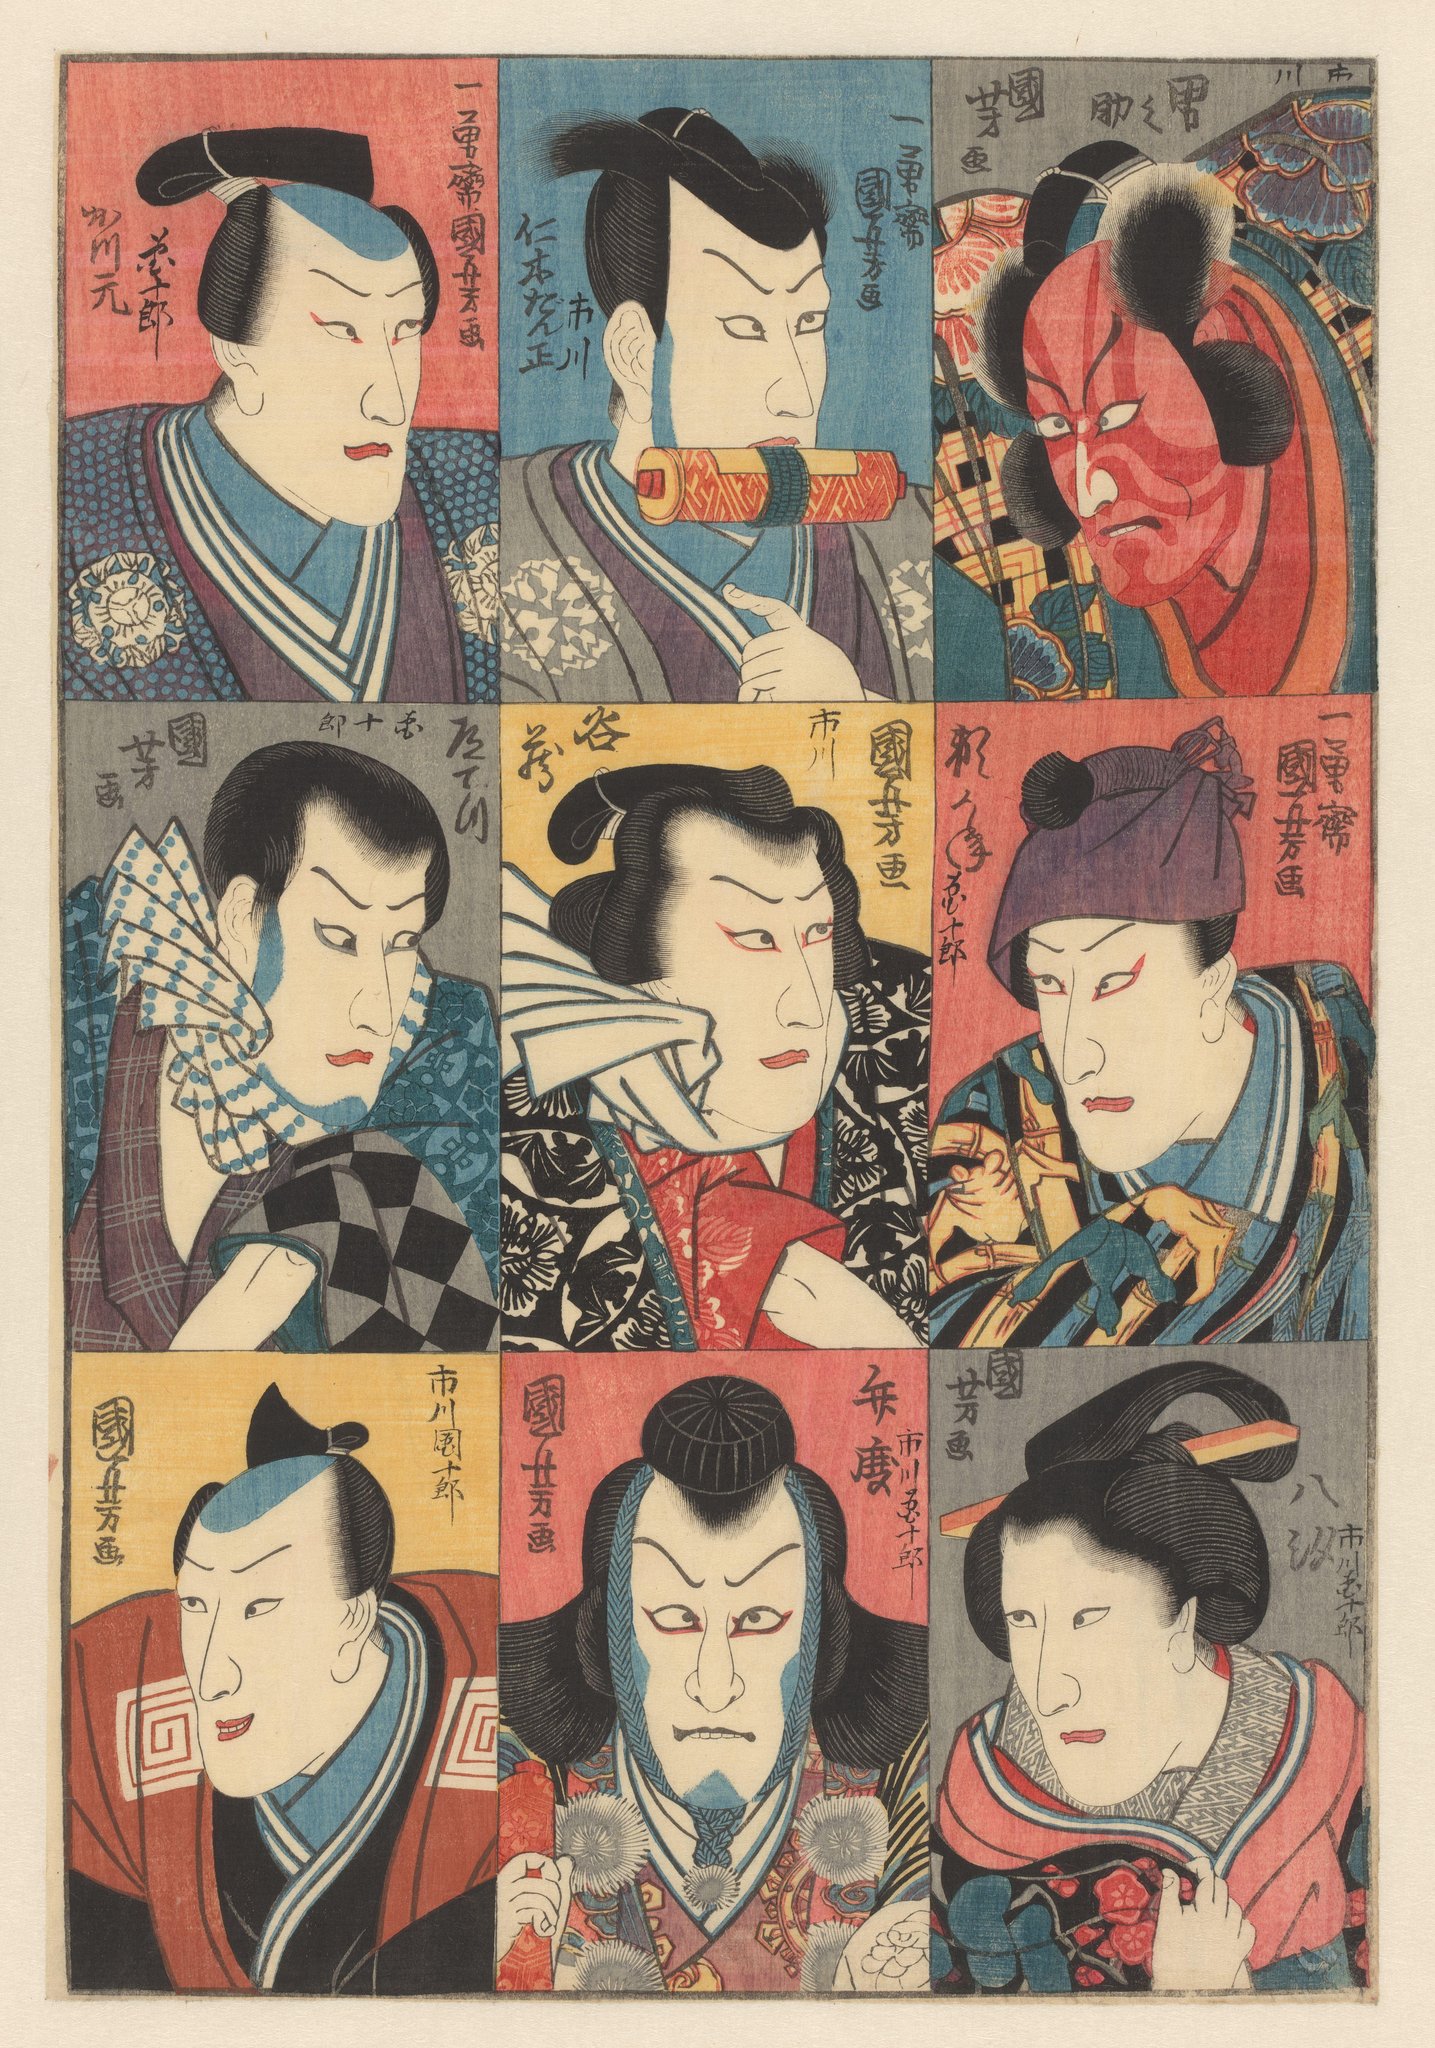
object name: print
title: Ichikawa Danjûrô VIII in eight different roles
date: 1849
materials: paper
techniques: woodcut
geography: japan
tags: portrait of actor, actress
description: Negen busteportretten van kabuki acteur Ichikawa Danjurô VIII in acht verschillende rollen.